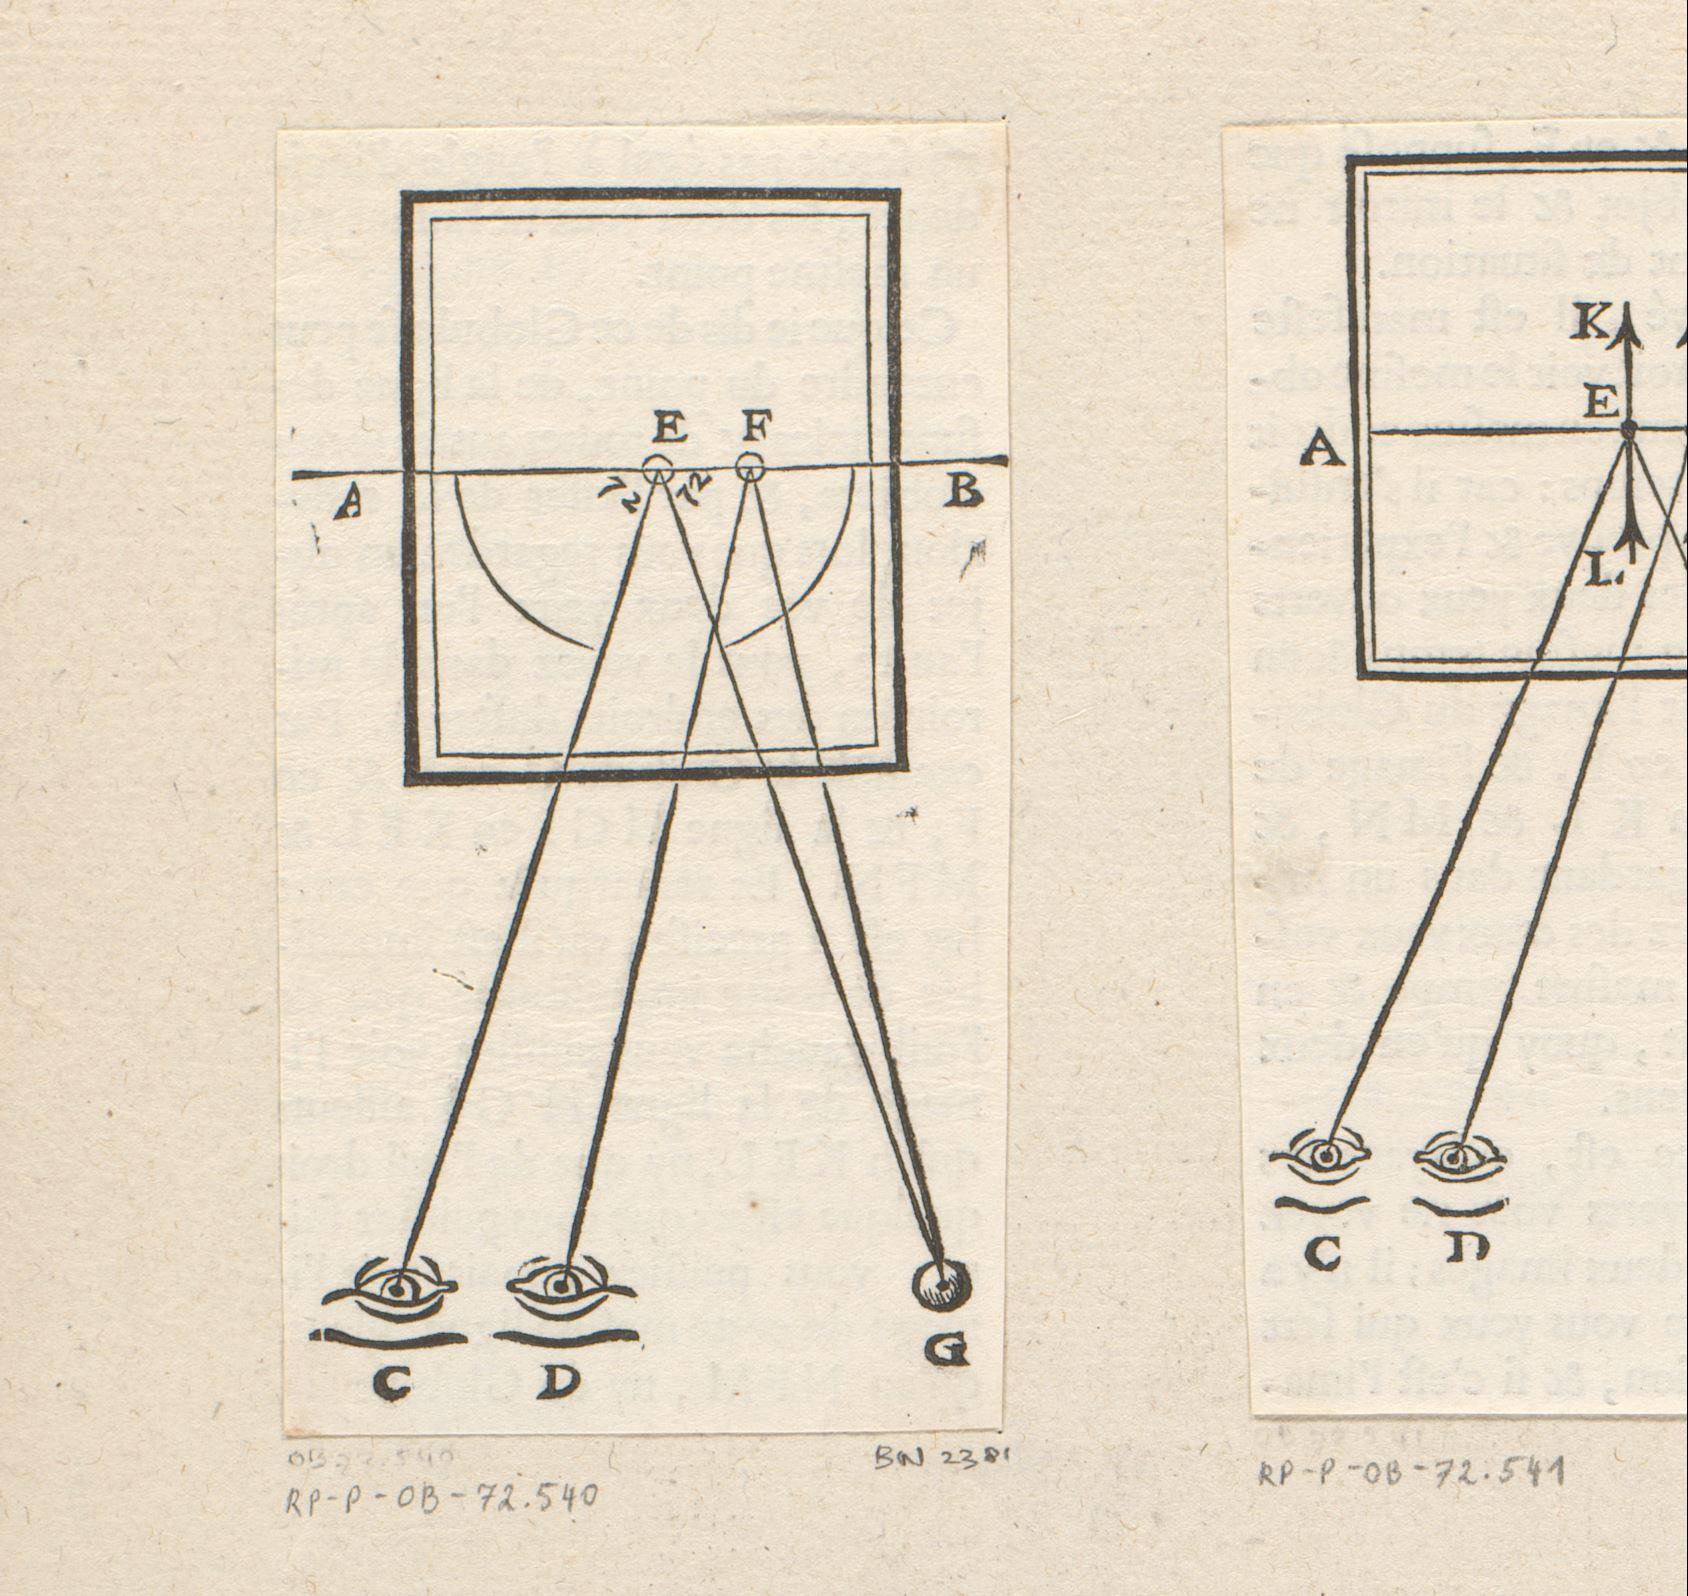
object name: book illustration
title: Ogen die via een spiegel naar een voorwerp kijken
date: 1679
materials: paper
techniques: letterpress printing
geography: france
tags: optics, mirror, eyes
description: Prent uit: Leclerc, Sébastien. Discours touchant le point de veue, dans lequel il est prouvé que les choses qu'on voit (...). Parijs: Thomas Jolly, 1679.